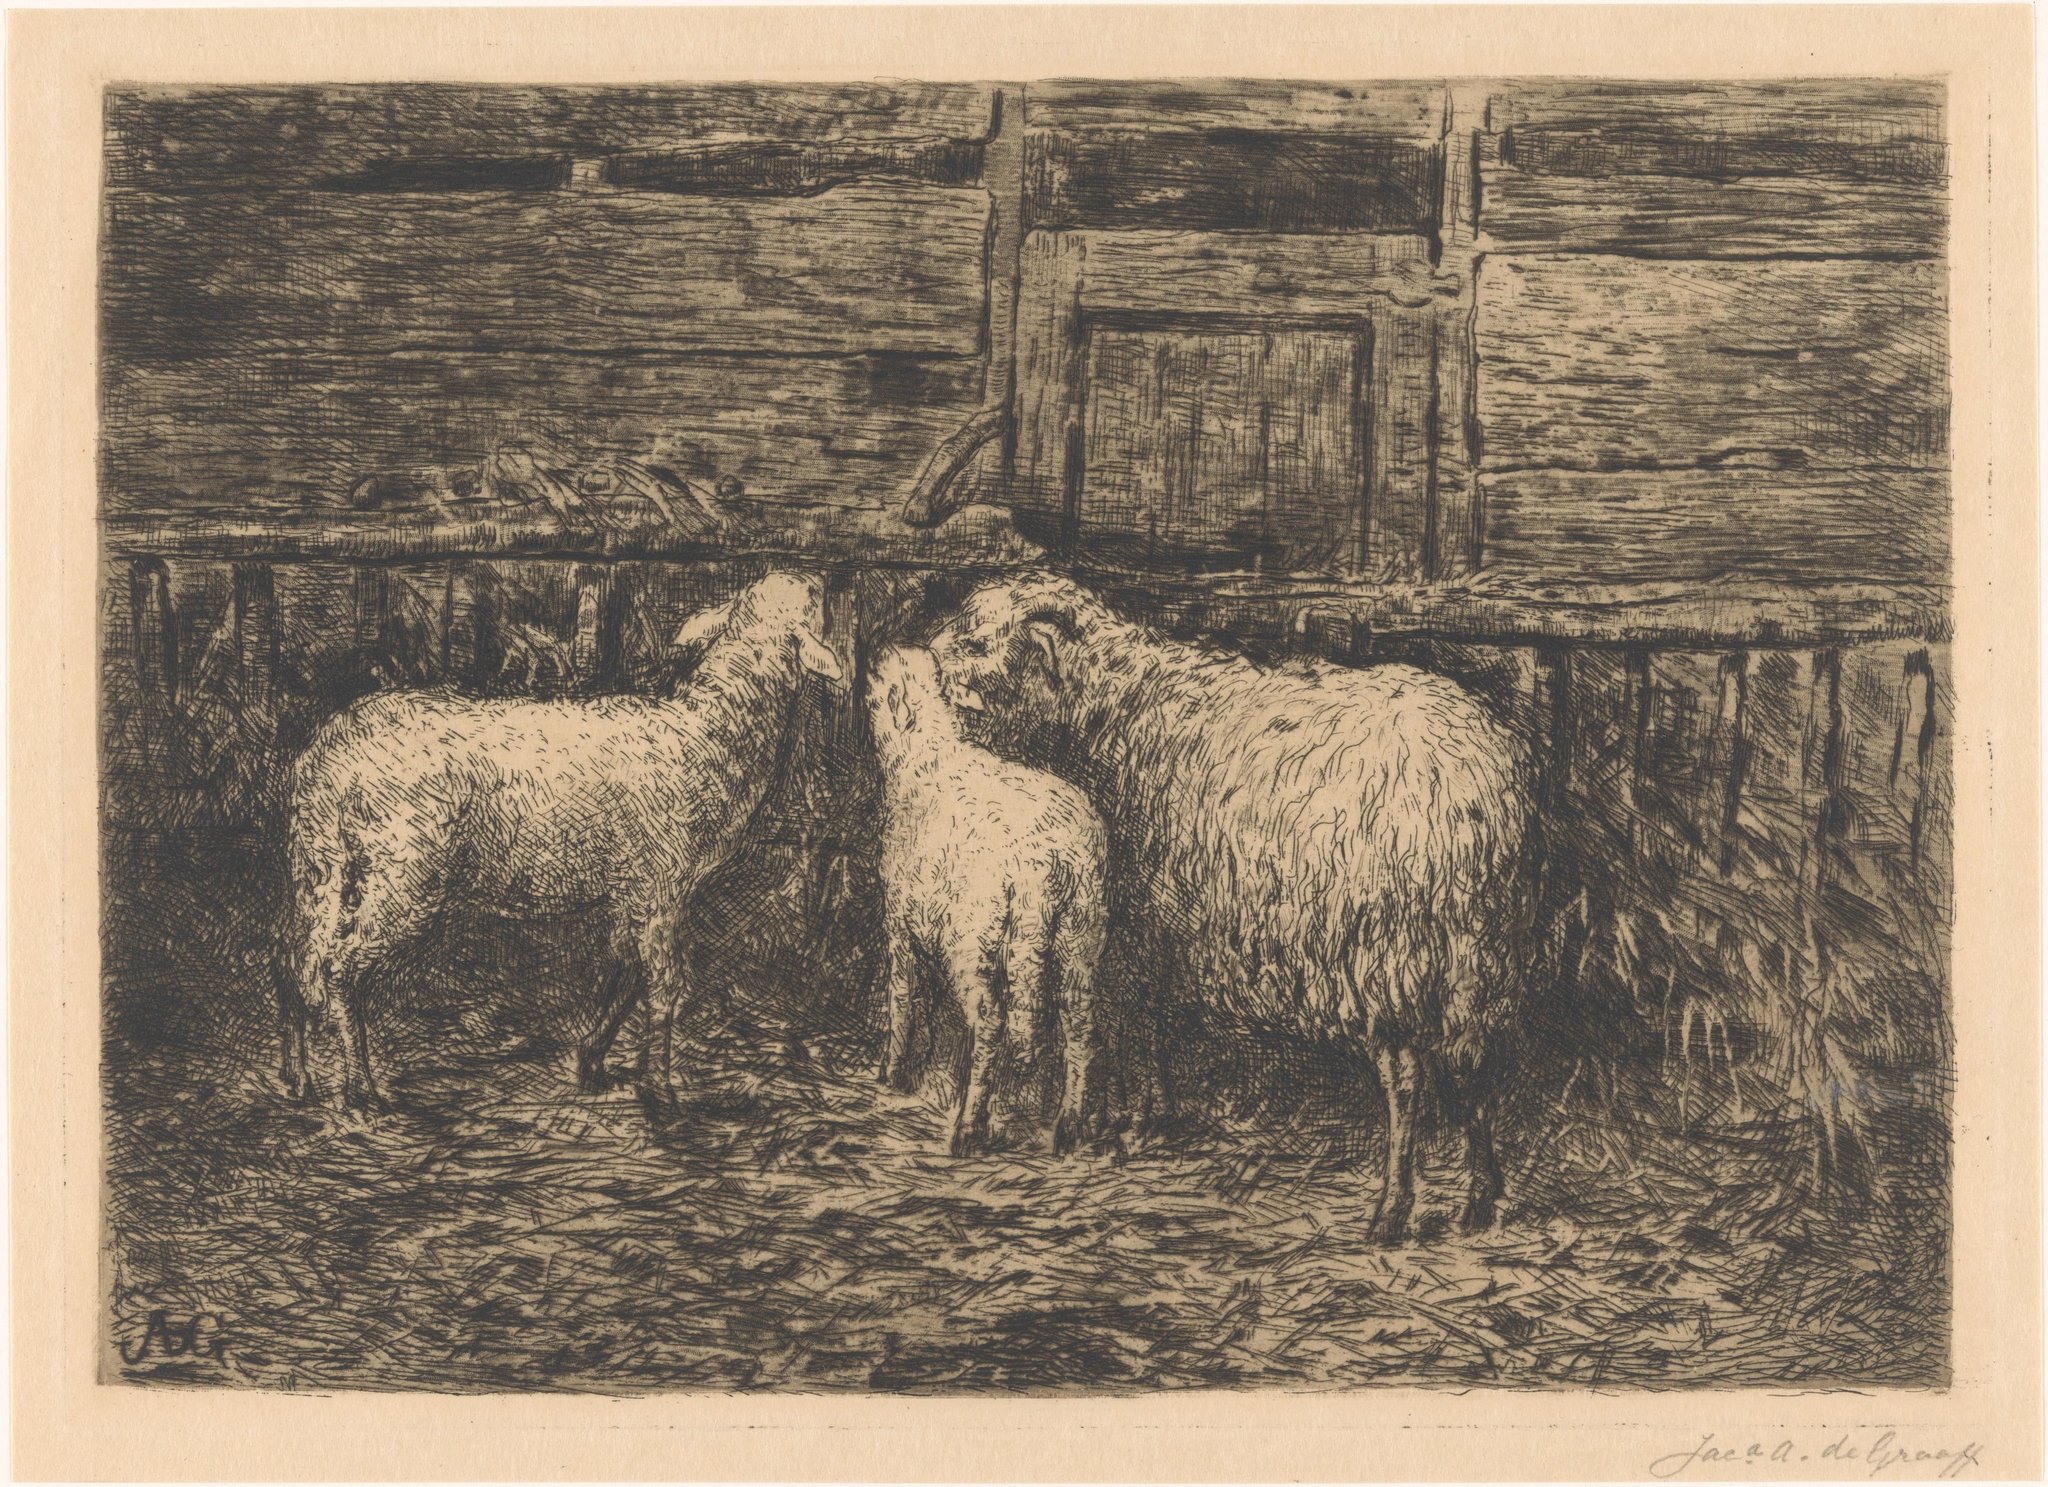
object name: print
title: Schapen in een stal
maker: jacoba de graaff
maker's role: print maker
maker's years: 1857-1940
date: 1867-1911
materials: paper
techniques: etching, intaglio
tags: sheep, stall, stable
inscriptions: collector's mark: Lugt 2228